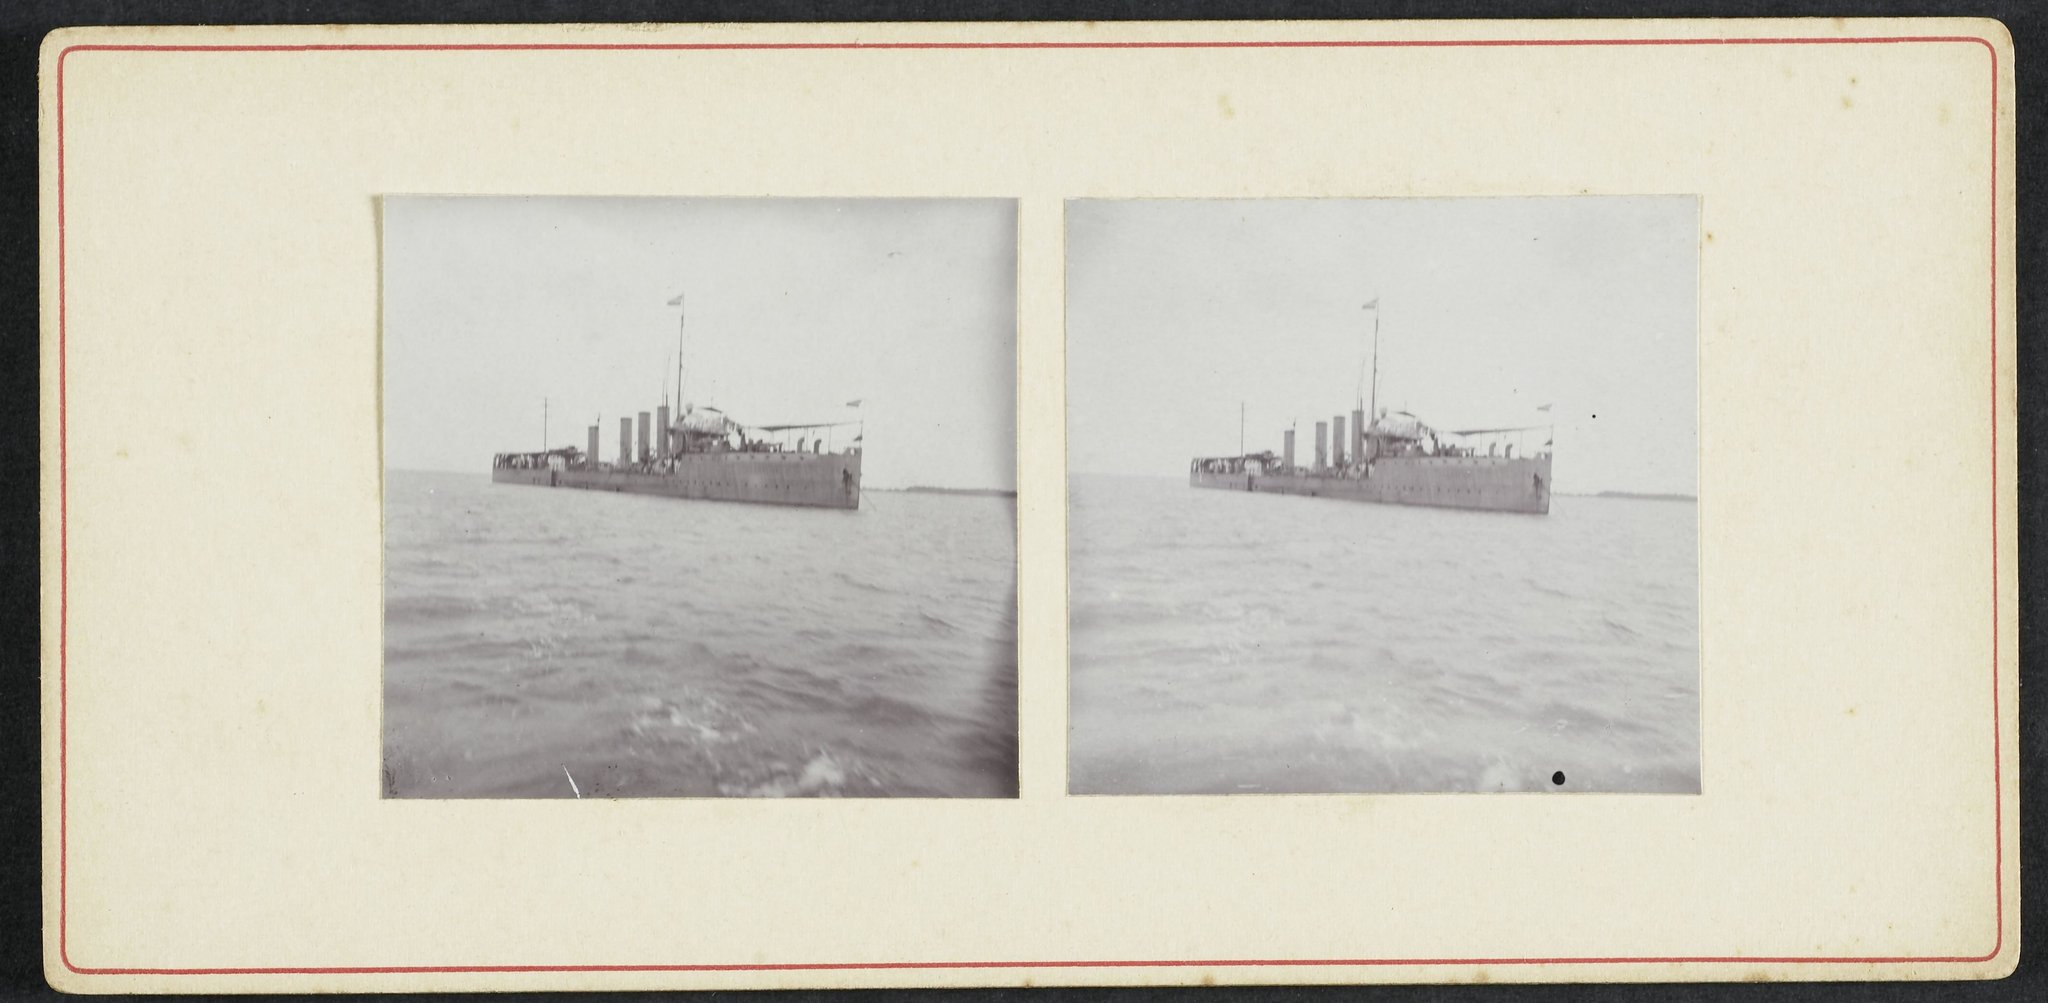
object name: stereograph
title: Nederlands schip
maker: robert julius boers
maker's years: 1867-1932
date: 1900-1922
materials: cardboard, photographic support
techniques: gelatin silver print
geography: bangka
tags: robert julius boers, dutch east indies, the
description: Een Nederlands stoomschip, liggend voor anker. Onderdeel van een groep stereofoto's van Robert Julius Boers, chef van het staatsbedrijf de Banka-tinwinning op Banka, uit de periode ca. 1900-1922.